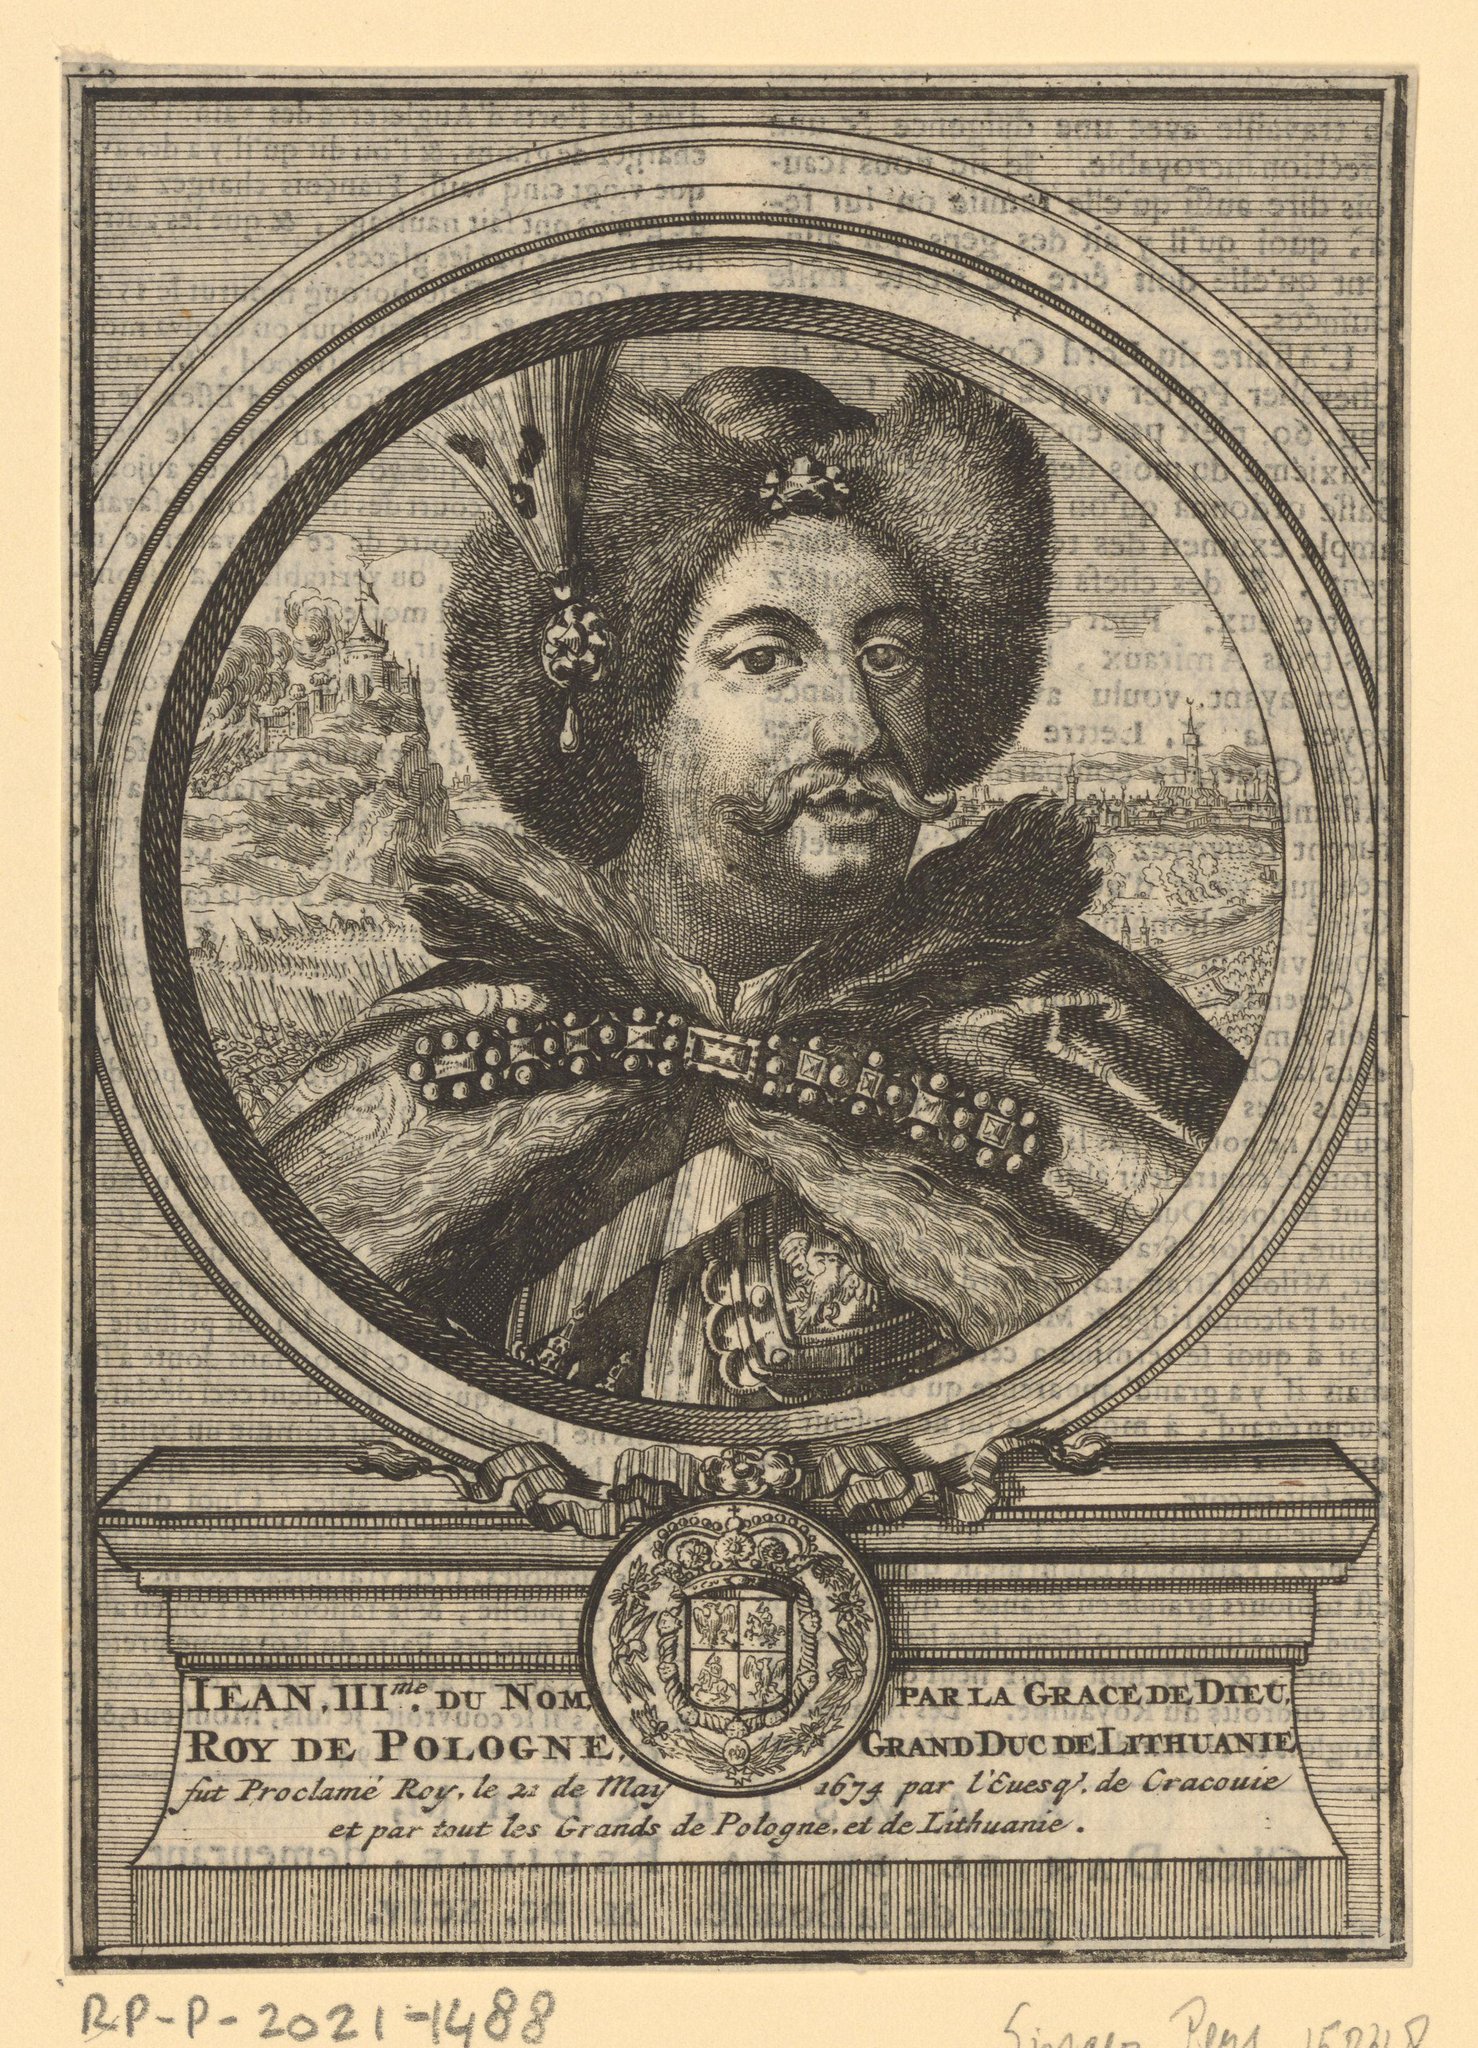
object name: print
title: Portret van Jan III Sobieski, koning van Polen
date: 1694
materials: paper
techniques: etching, letterpress printing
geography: amsterdam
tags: jan iii sobieski (koning van polen), historical persons, king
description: Prent uit: Lettres sur l'état présent de l'Europe: avec les plans de ses forteresses (...). Amsterdam: Daniel de Lafeuille, 1693. Datering 1693 op titelblad van publicatie, maar in de tekst van het boek staat het jaar 1694 gedrukt.